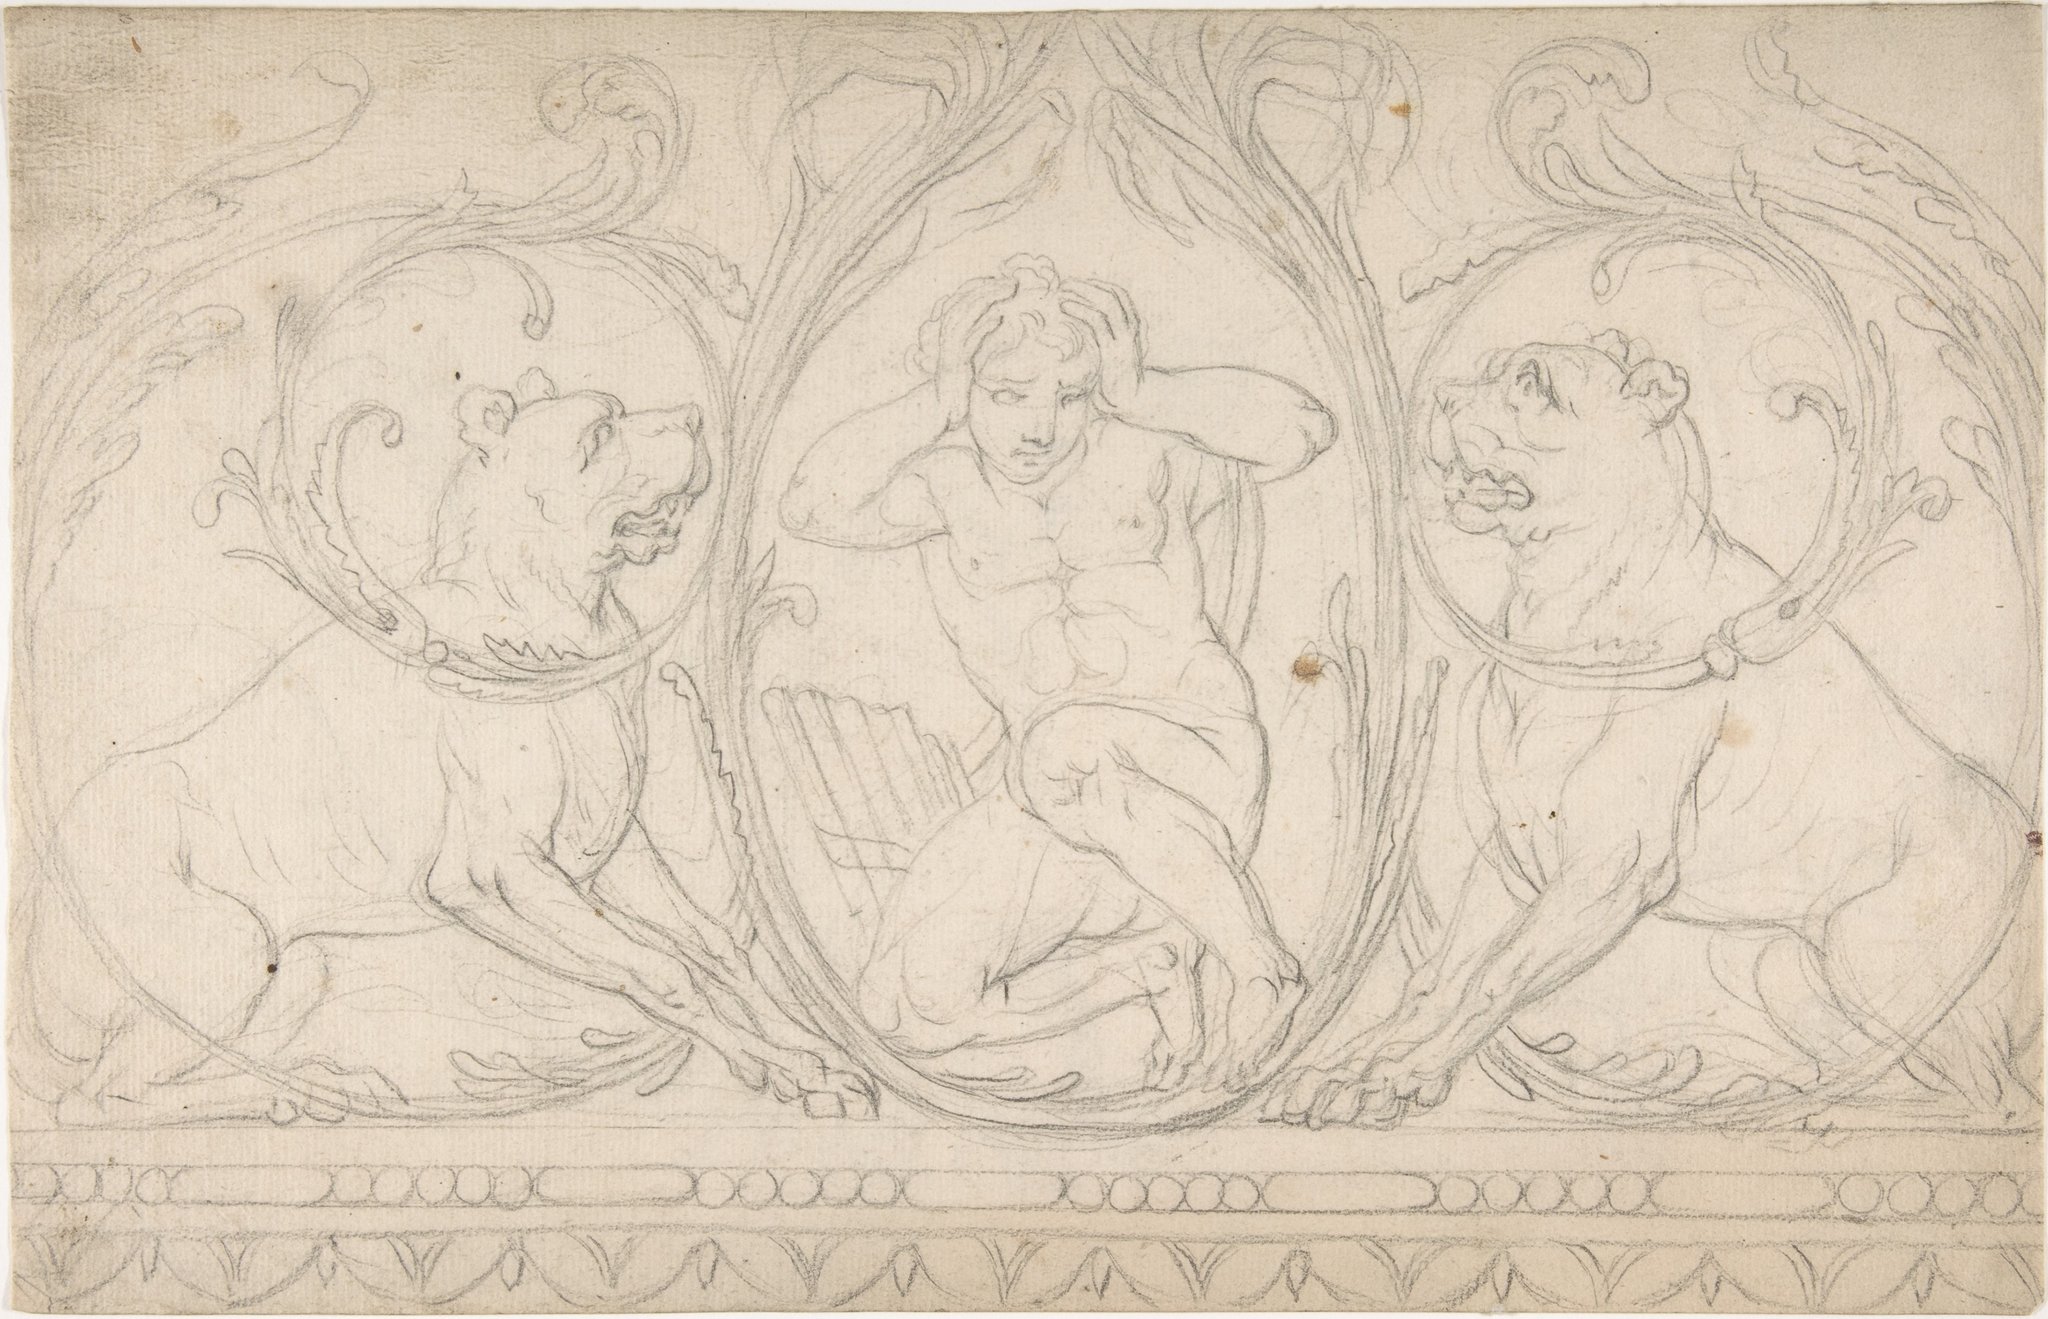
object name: drawing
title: Ornament Containing a Nude Male with Pipes Framed by Two Dogs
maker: anonymous, german, 19th century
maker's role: artist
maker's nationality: german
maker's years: 1800-1899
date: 1780-1820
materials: graphite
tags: male nudes,dogs